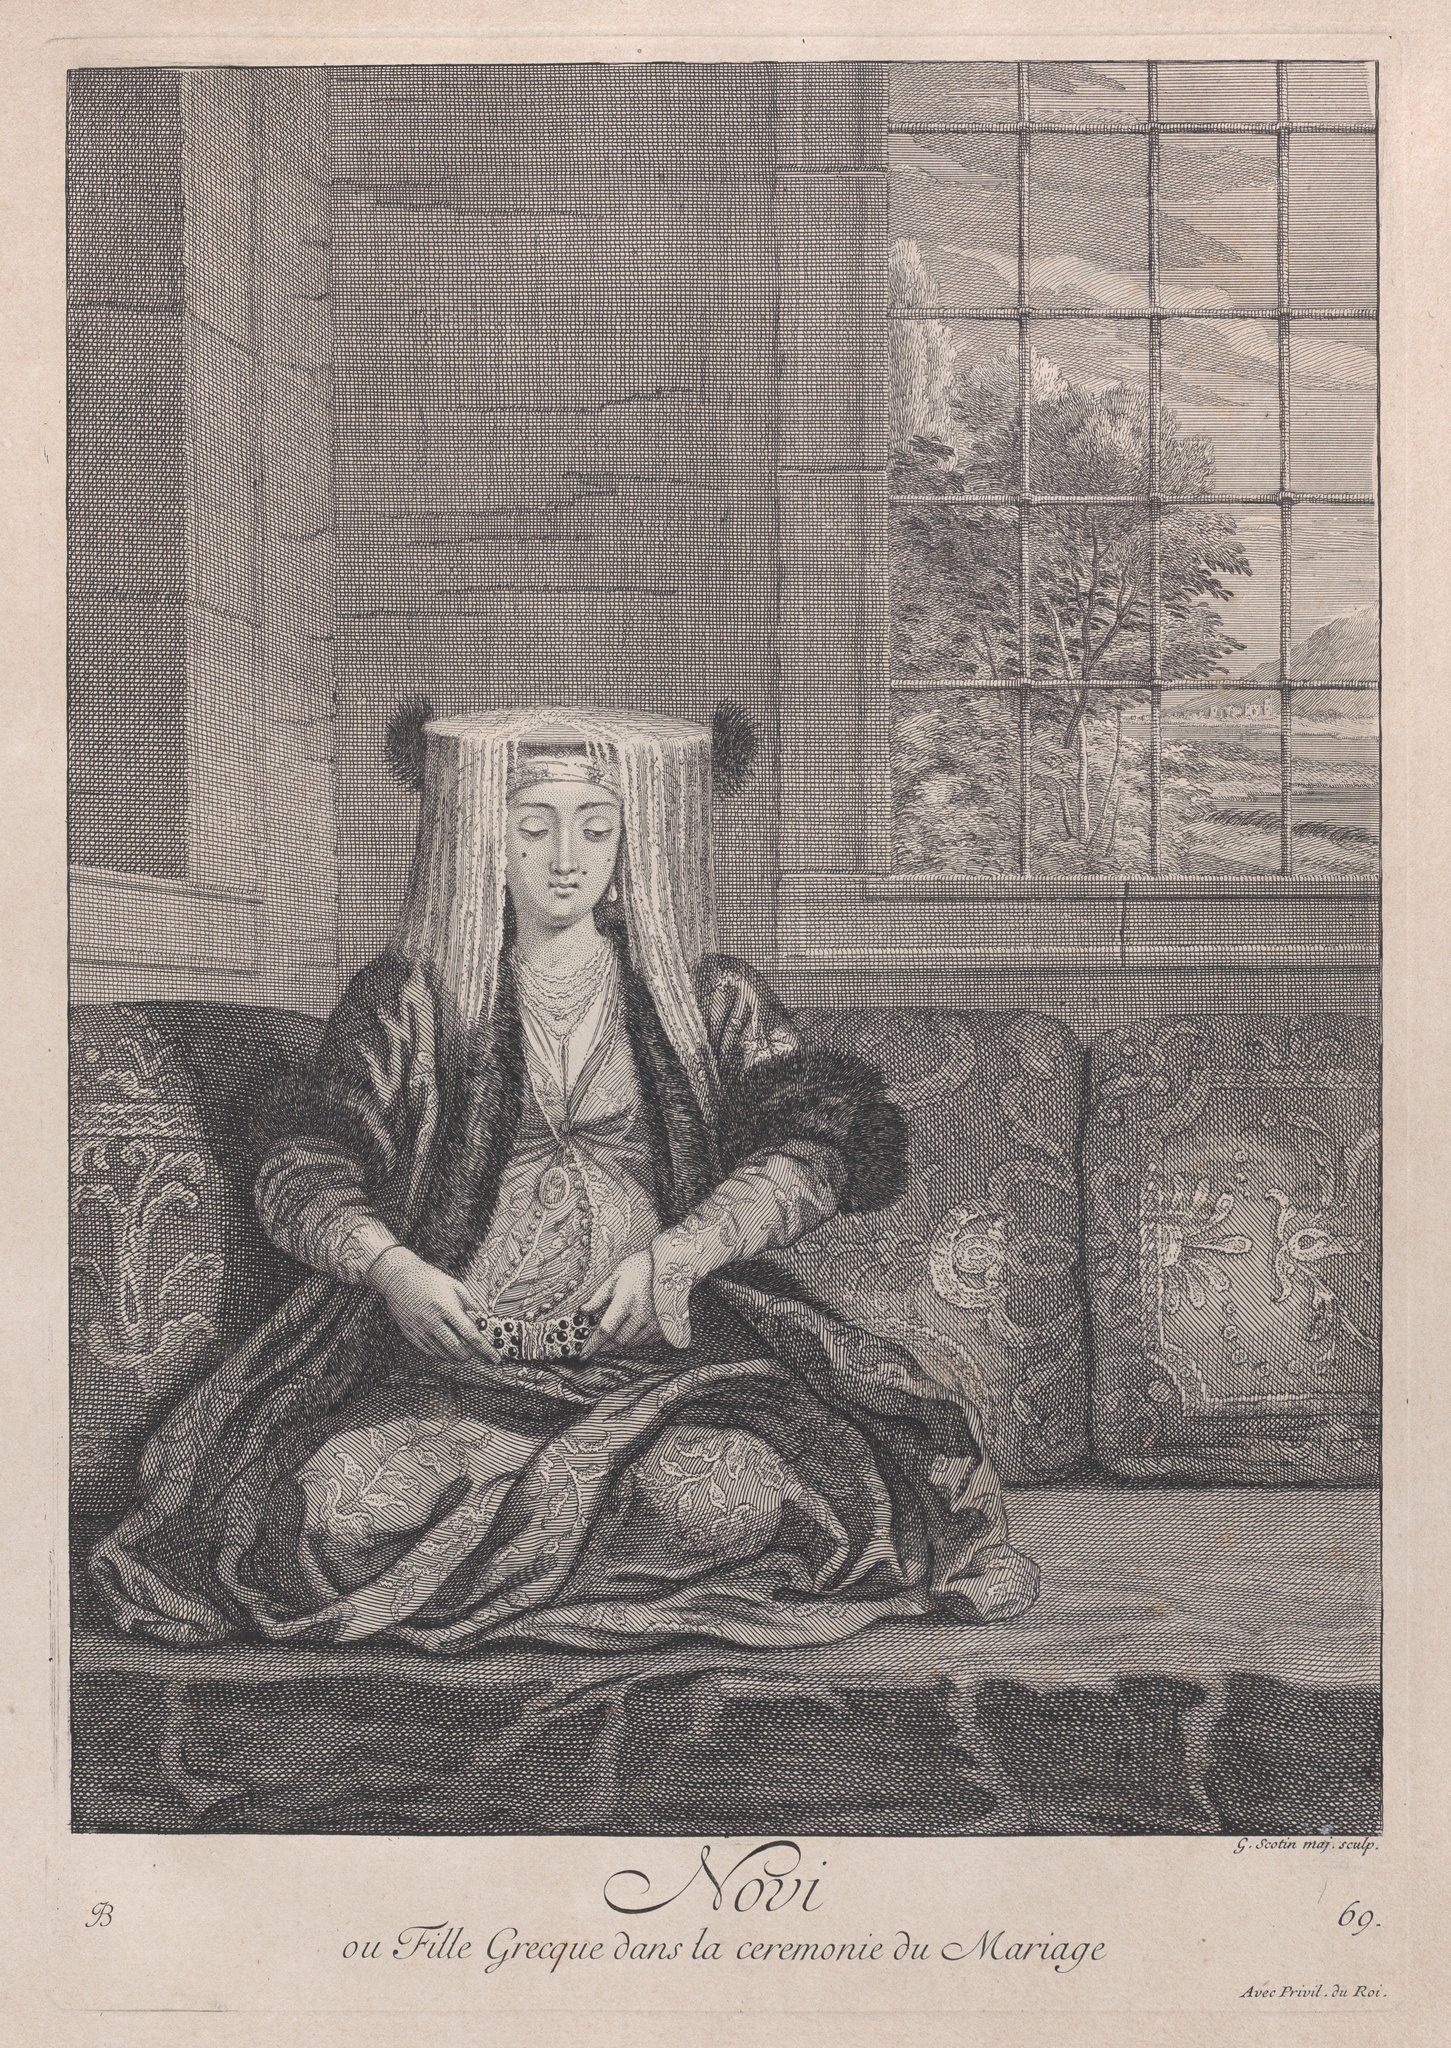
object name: print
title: Novi, ou Fille Grecque dans la ceremonie du Mariage, plate 69 from "Recueil de cent estampes représentent differentes nations du Levant"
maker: jean baptiste vanmour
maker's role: artist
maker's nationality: french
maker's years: 1671-1737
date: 1714-1715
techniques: engraving, etching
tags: women